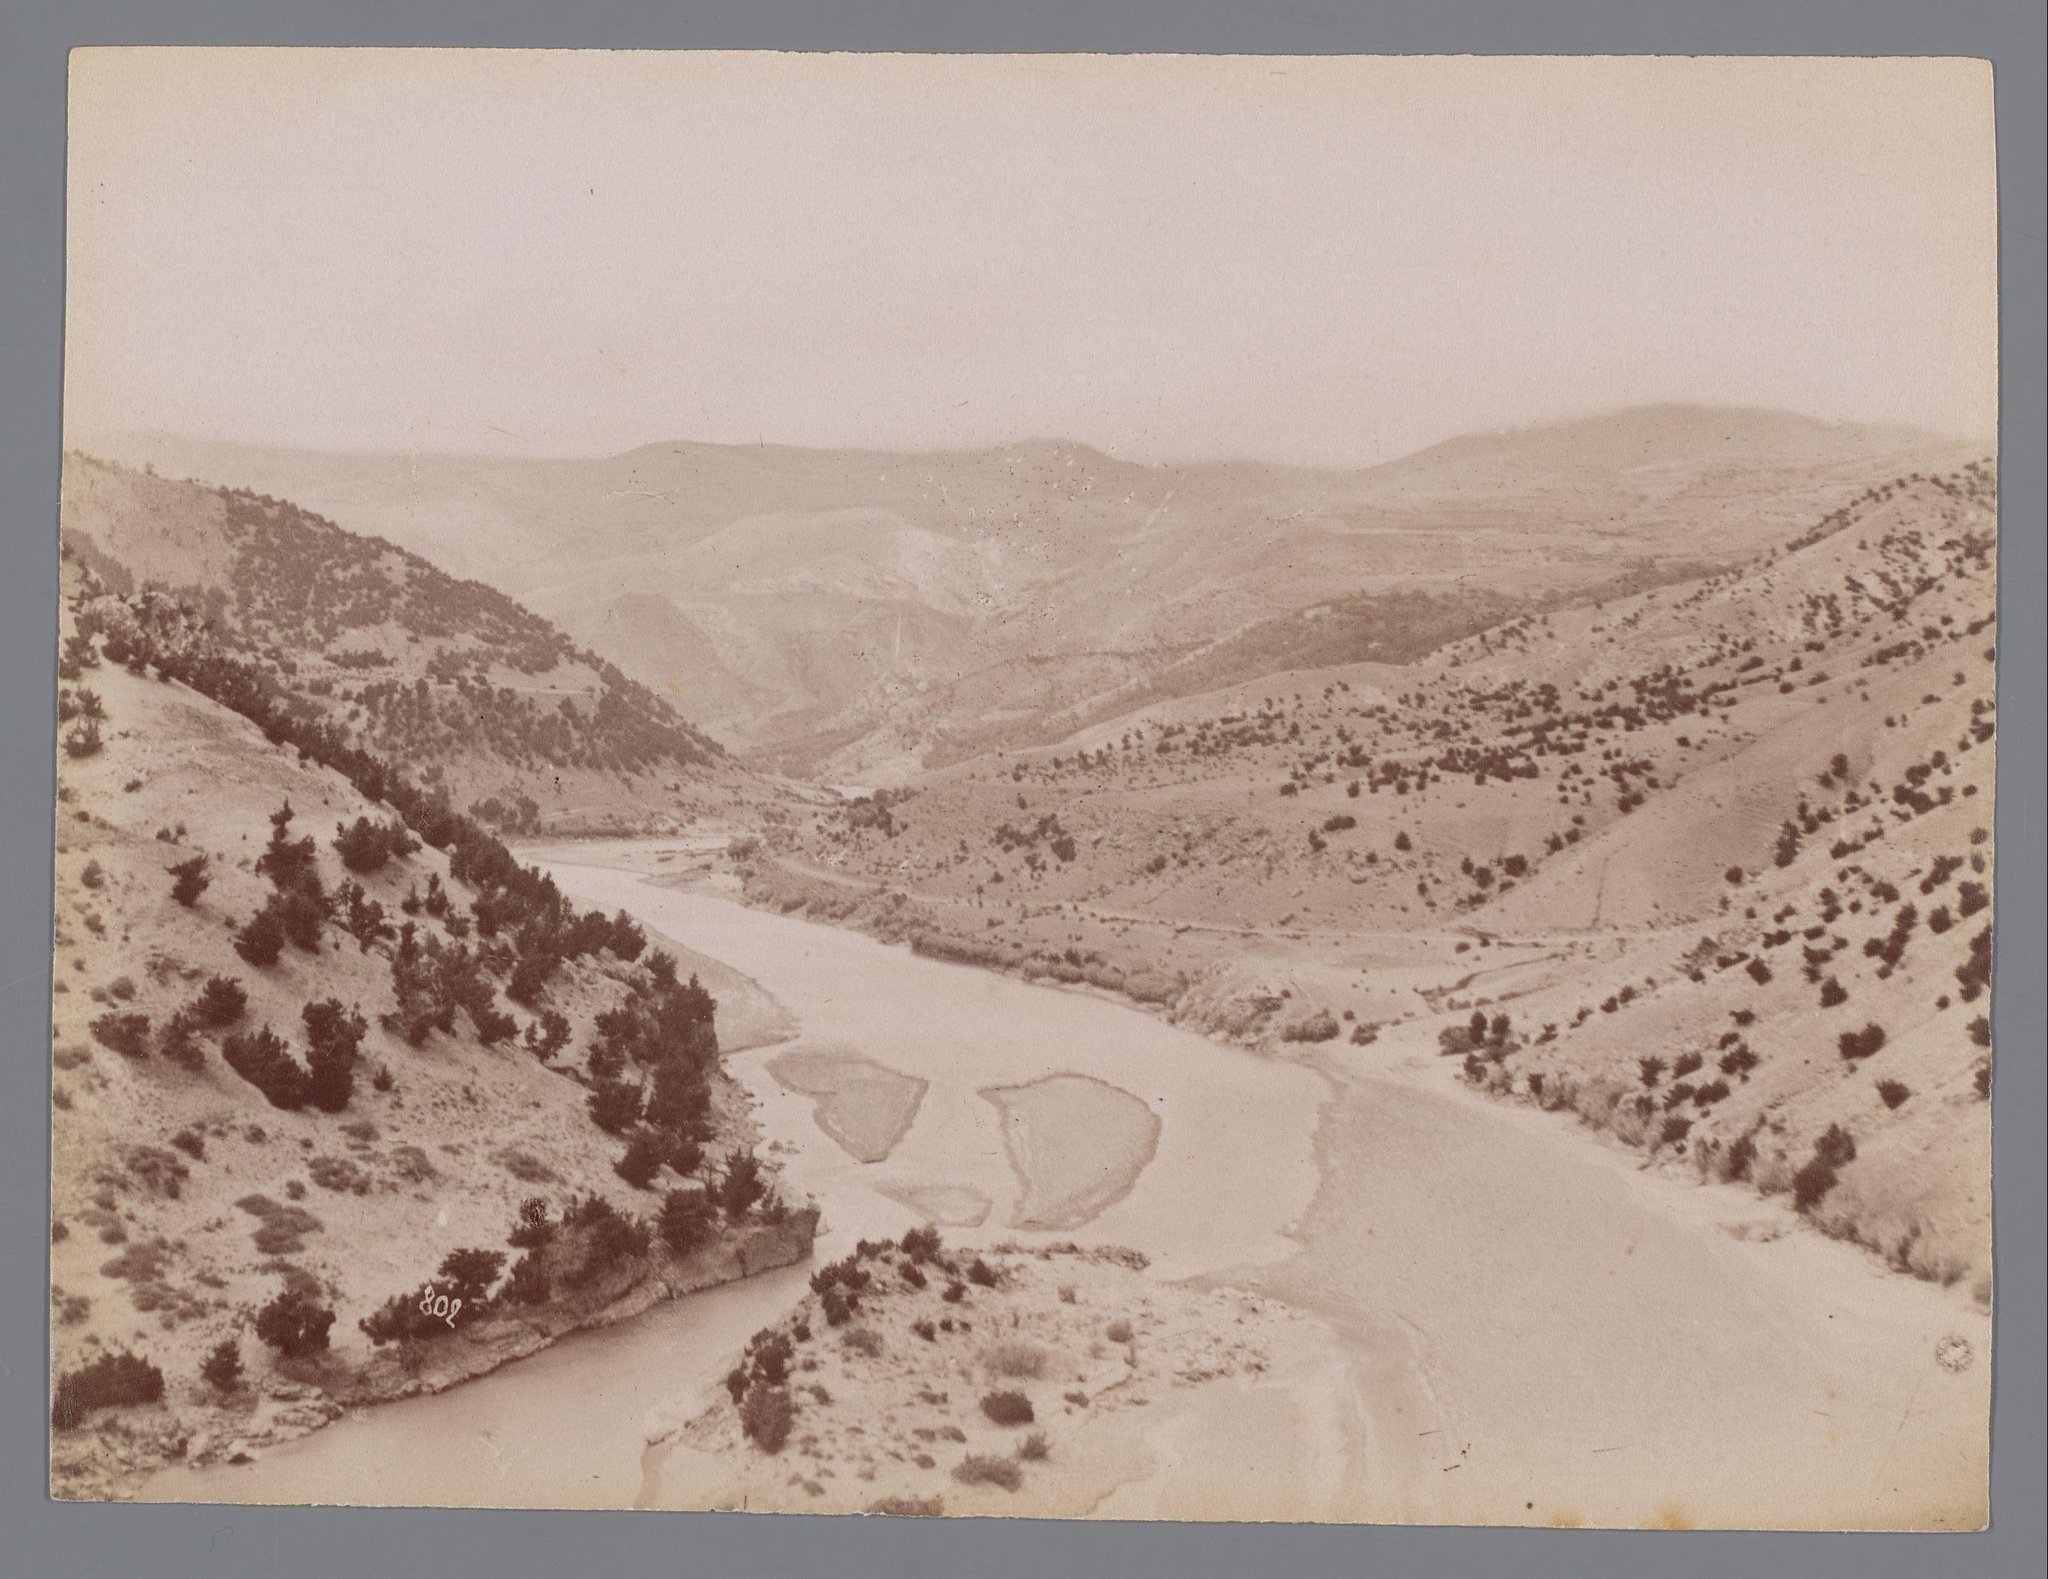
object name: photograph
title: Landschap met rivier en heuvels aan weerszijden ("La route de Rescht"), Iran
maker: antoine sevruguin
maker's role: fotograaf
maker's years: 1840-1933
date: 1880-1910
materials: paper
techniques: albumen print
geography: iran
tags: iran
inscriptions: inscription: ‘La route de Rescht’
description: Landschap met rivier en heuvels aan weerszijden ("La route de Rescht"), Iran.